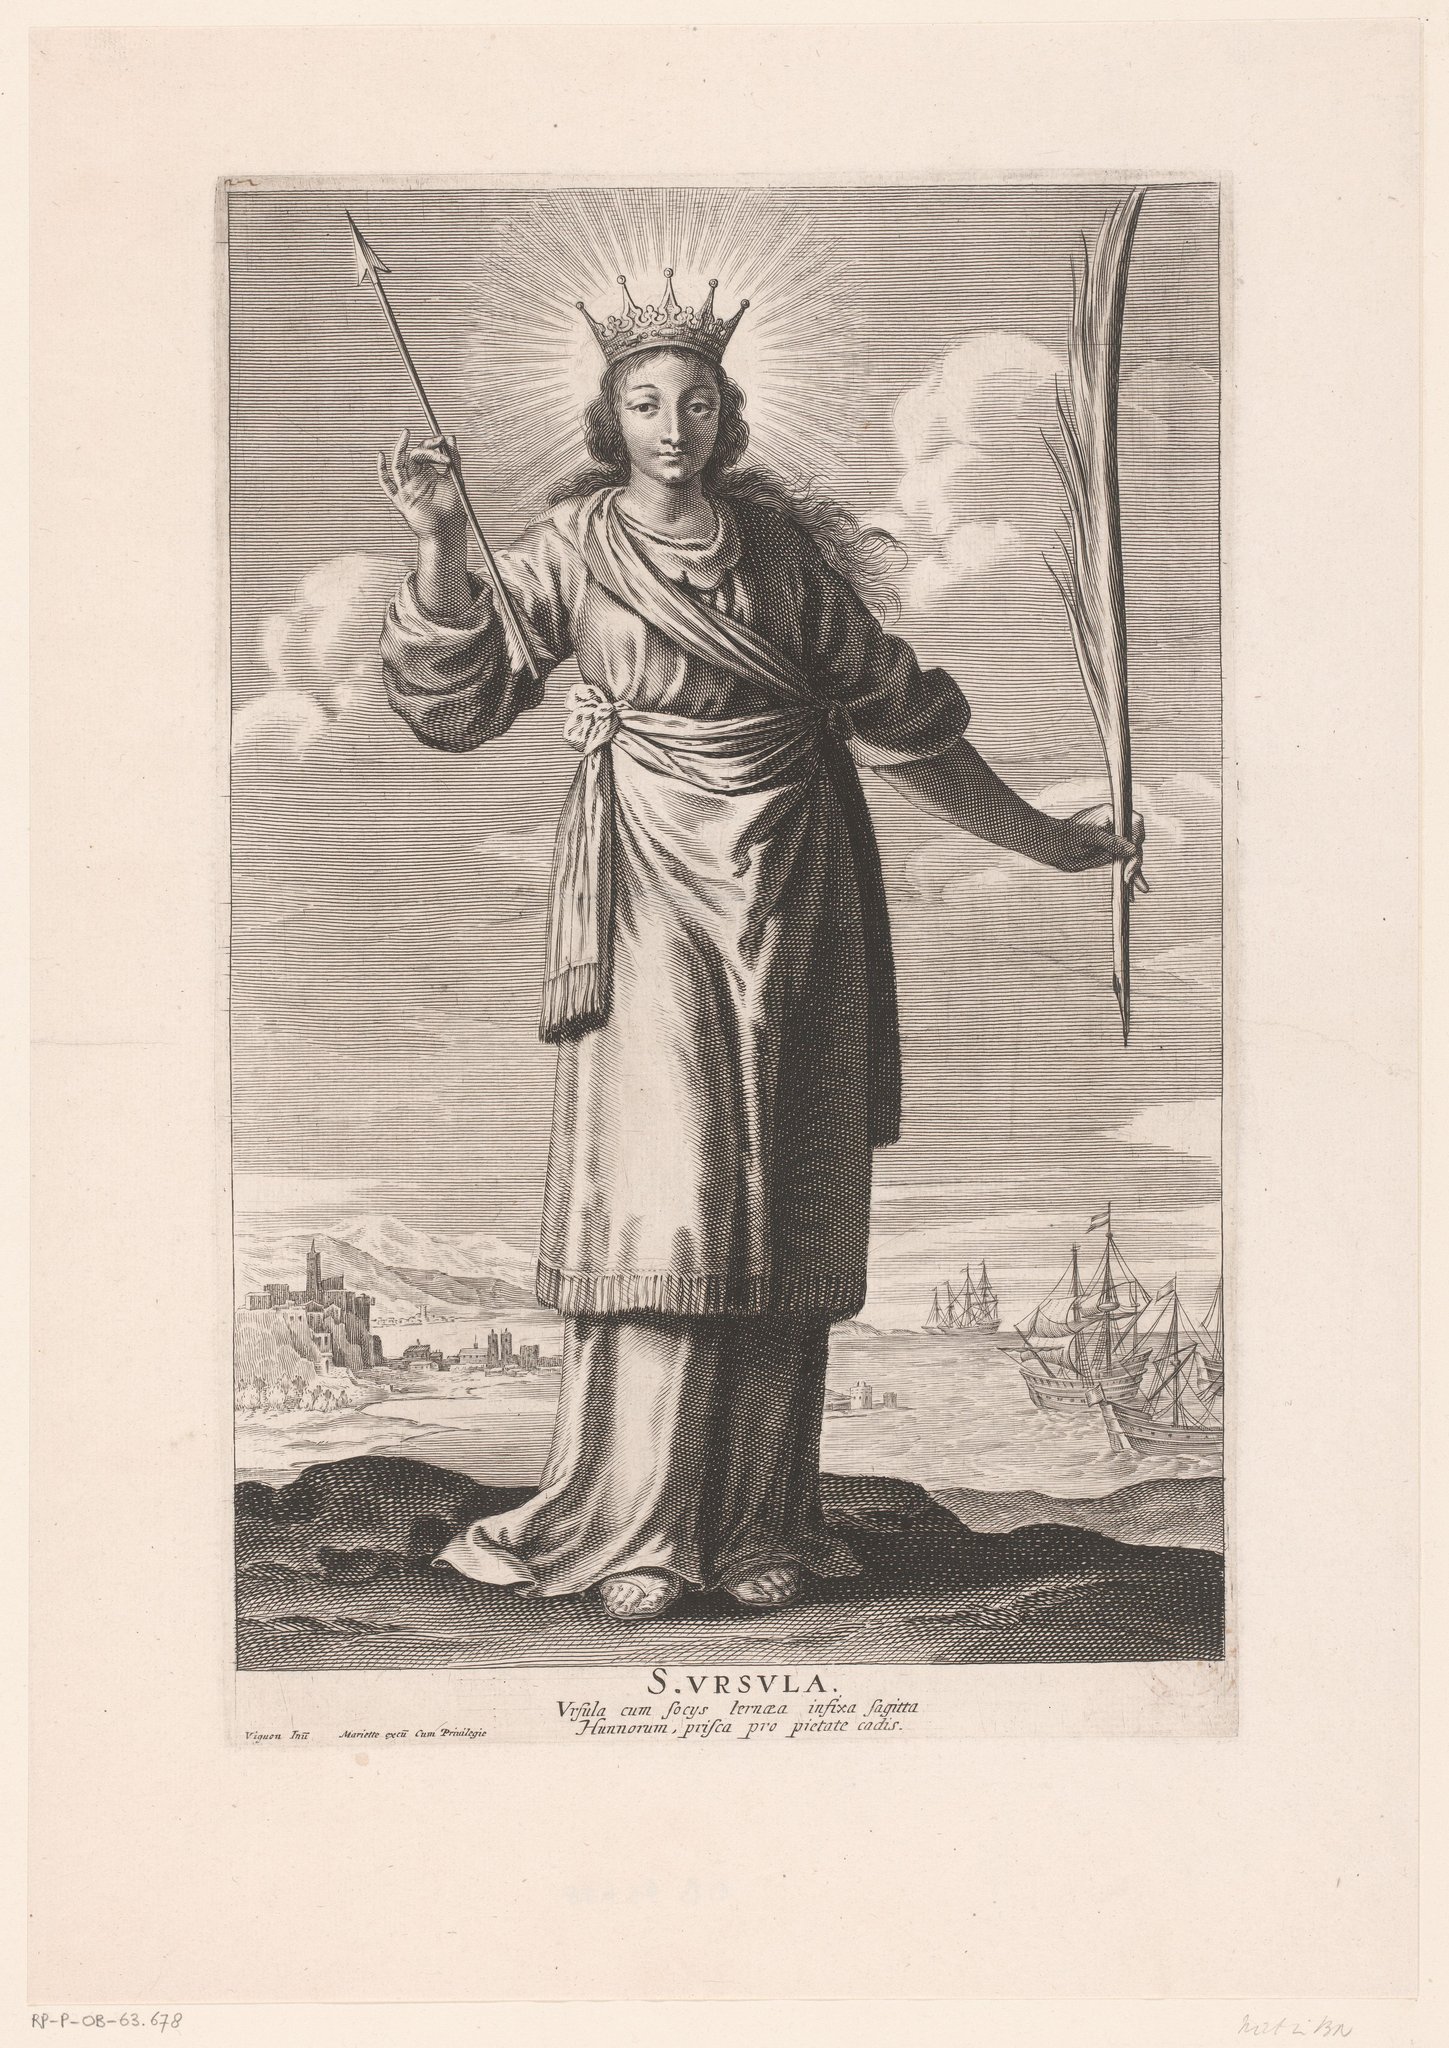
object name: print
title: S. Ursula.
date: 1632-1657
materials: paper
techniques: engraving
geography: paris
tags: the virgin martyr ursula of cologne; possible attributes: arrow, banner with red cross, cloak of ermine, crown, ship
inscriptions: collector's mark: Lugt 240, inscription: ‘2-2’